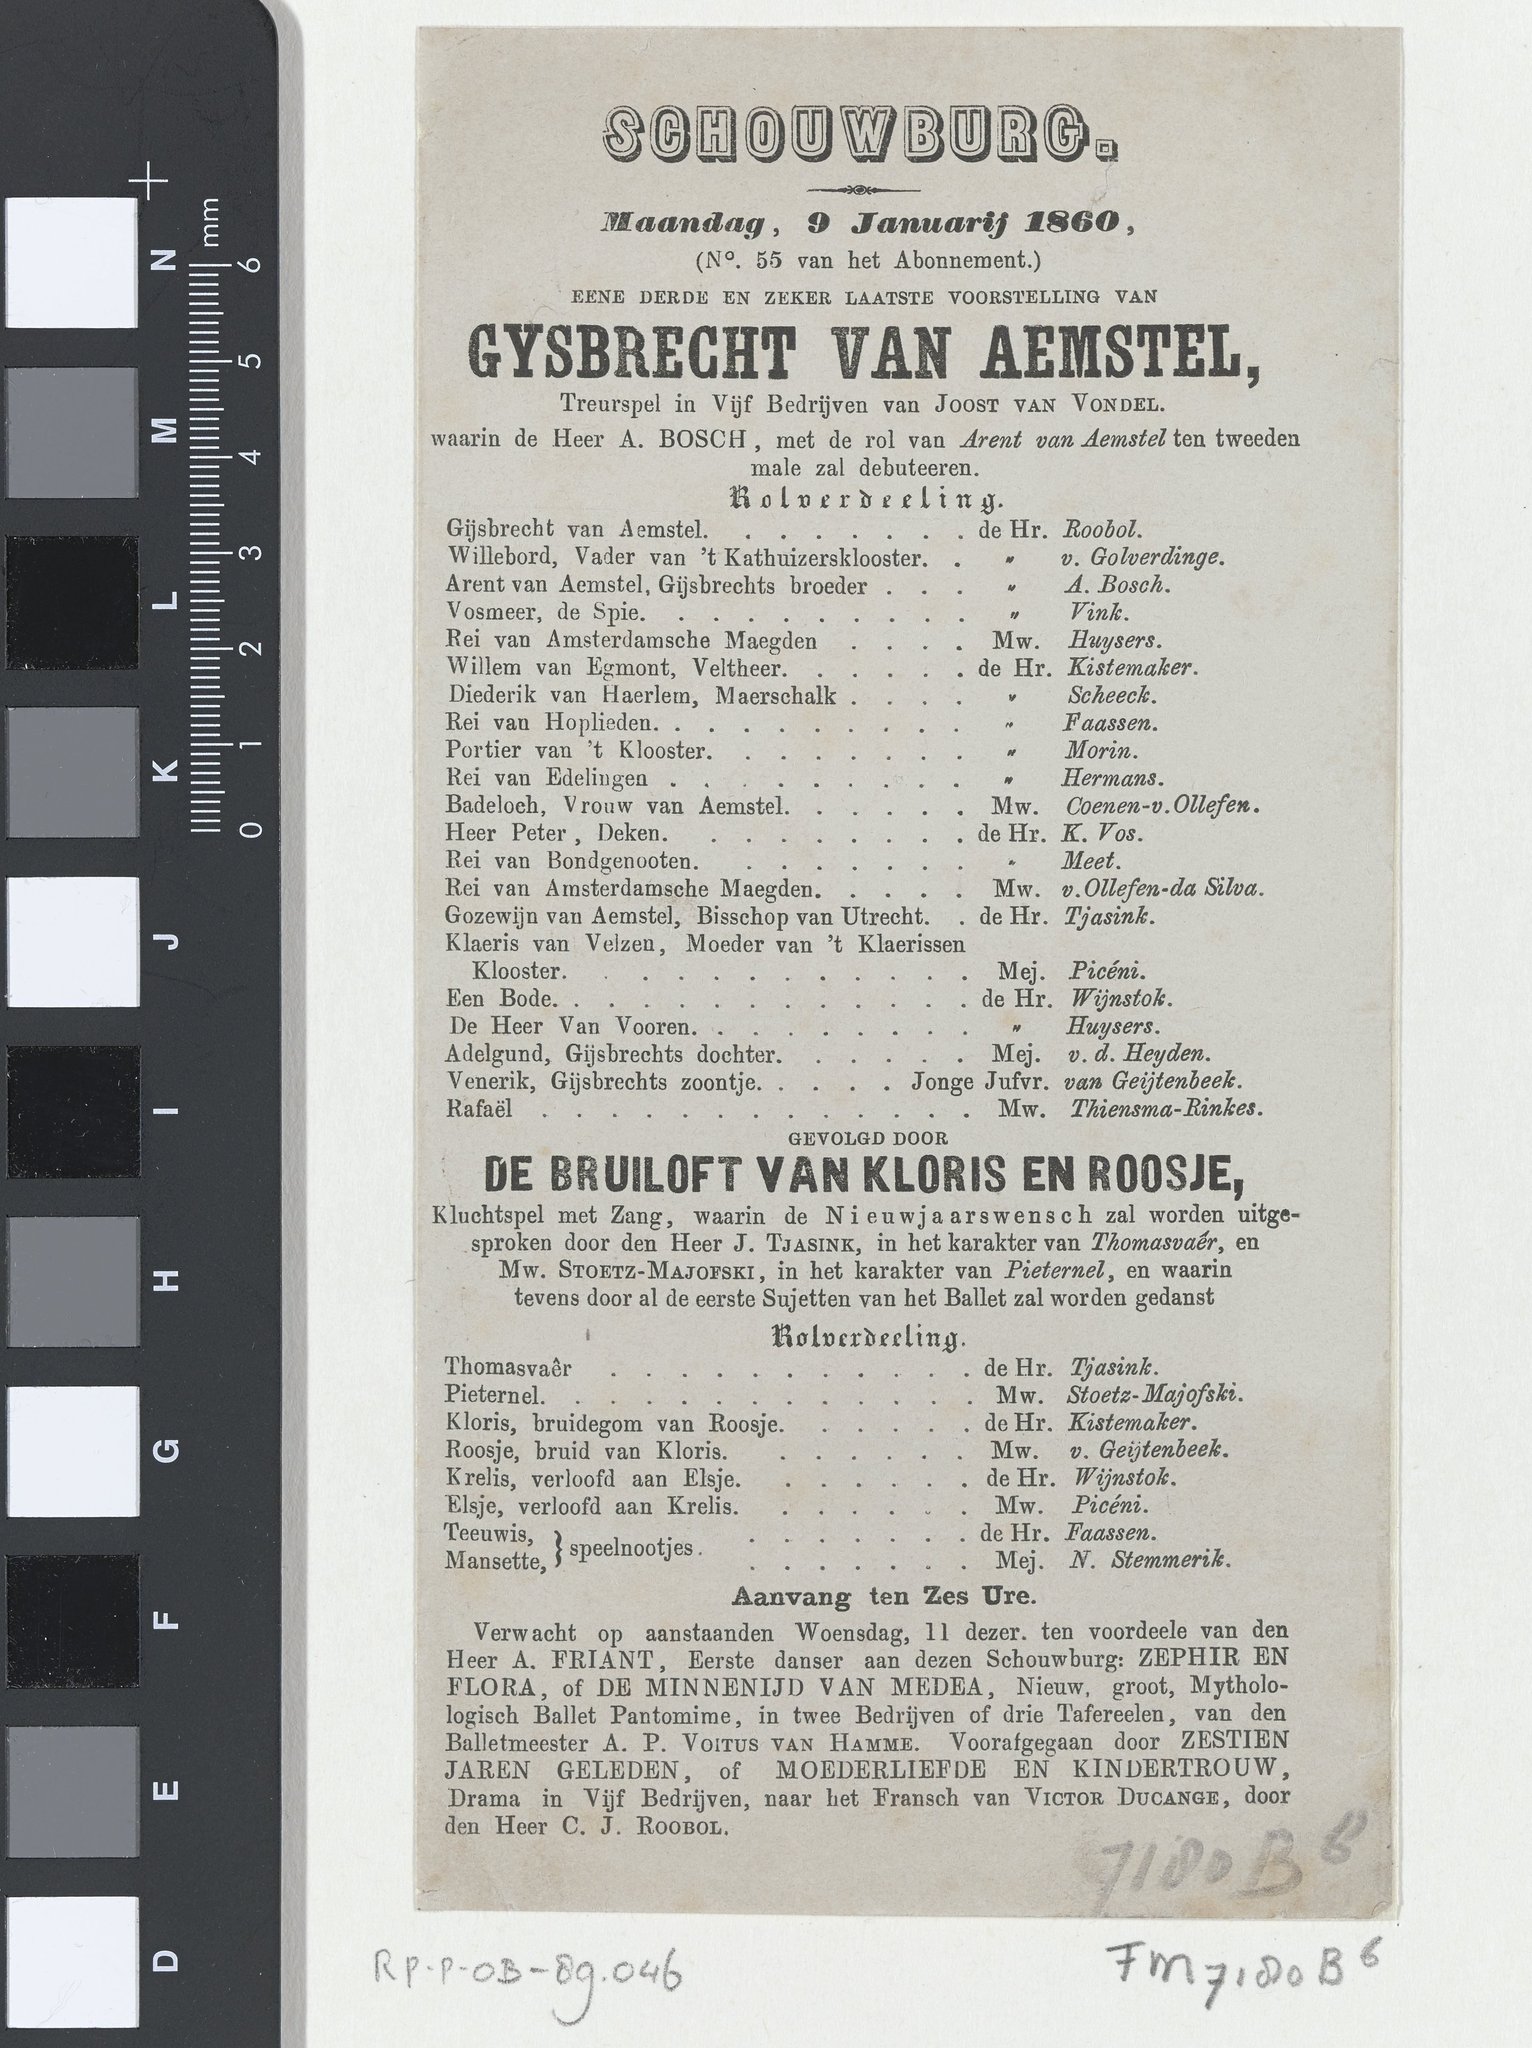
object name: programma, programmaboekje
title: Programma voor de opvoering van de Gijsbrecht van Aemstel in de Amsterdamse Schouwburg op 9 januari 1860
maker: Anonymous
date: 1860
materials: paper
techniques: letterpress printing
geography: amsterdam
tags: cologne, joost van den vondel, (vondel, gijsbrecht van aemstel) specific works of literature (with author, title)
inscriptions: collector's mark: Lugt 2228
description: Programma voor de opvoering van de Gijsbrecht van Aemstel in de Amsterdamse Schouwburg op 9 januari 1860. Rolverdeling voor de Gijsbrecht en het navolgende stuk 'De bruiloft van Kloris en Roosje'.